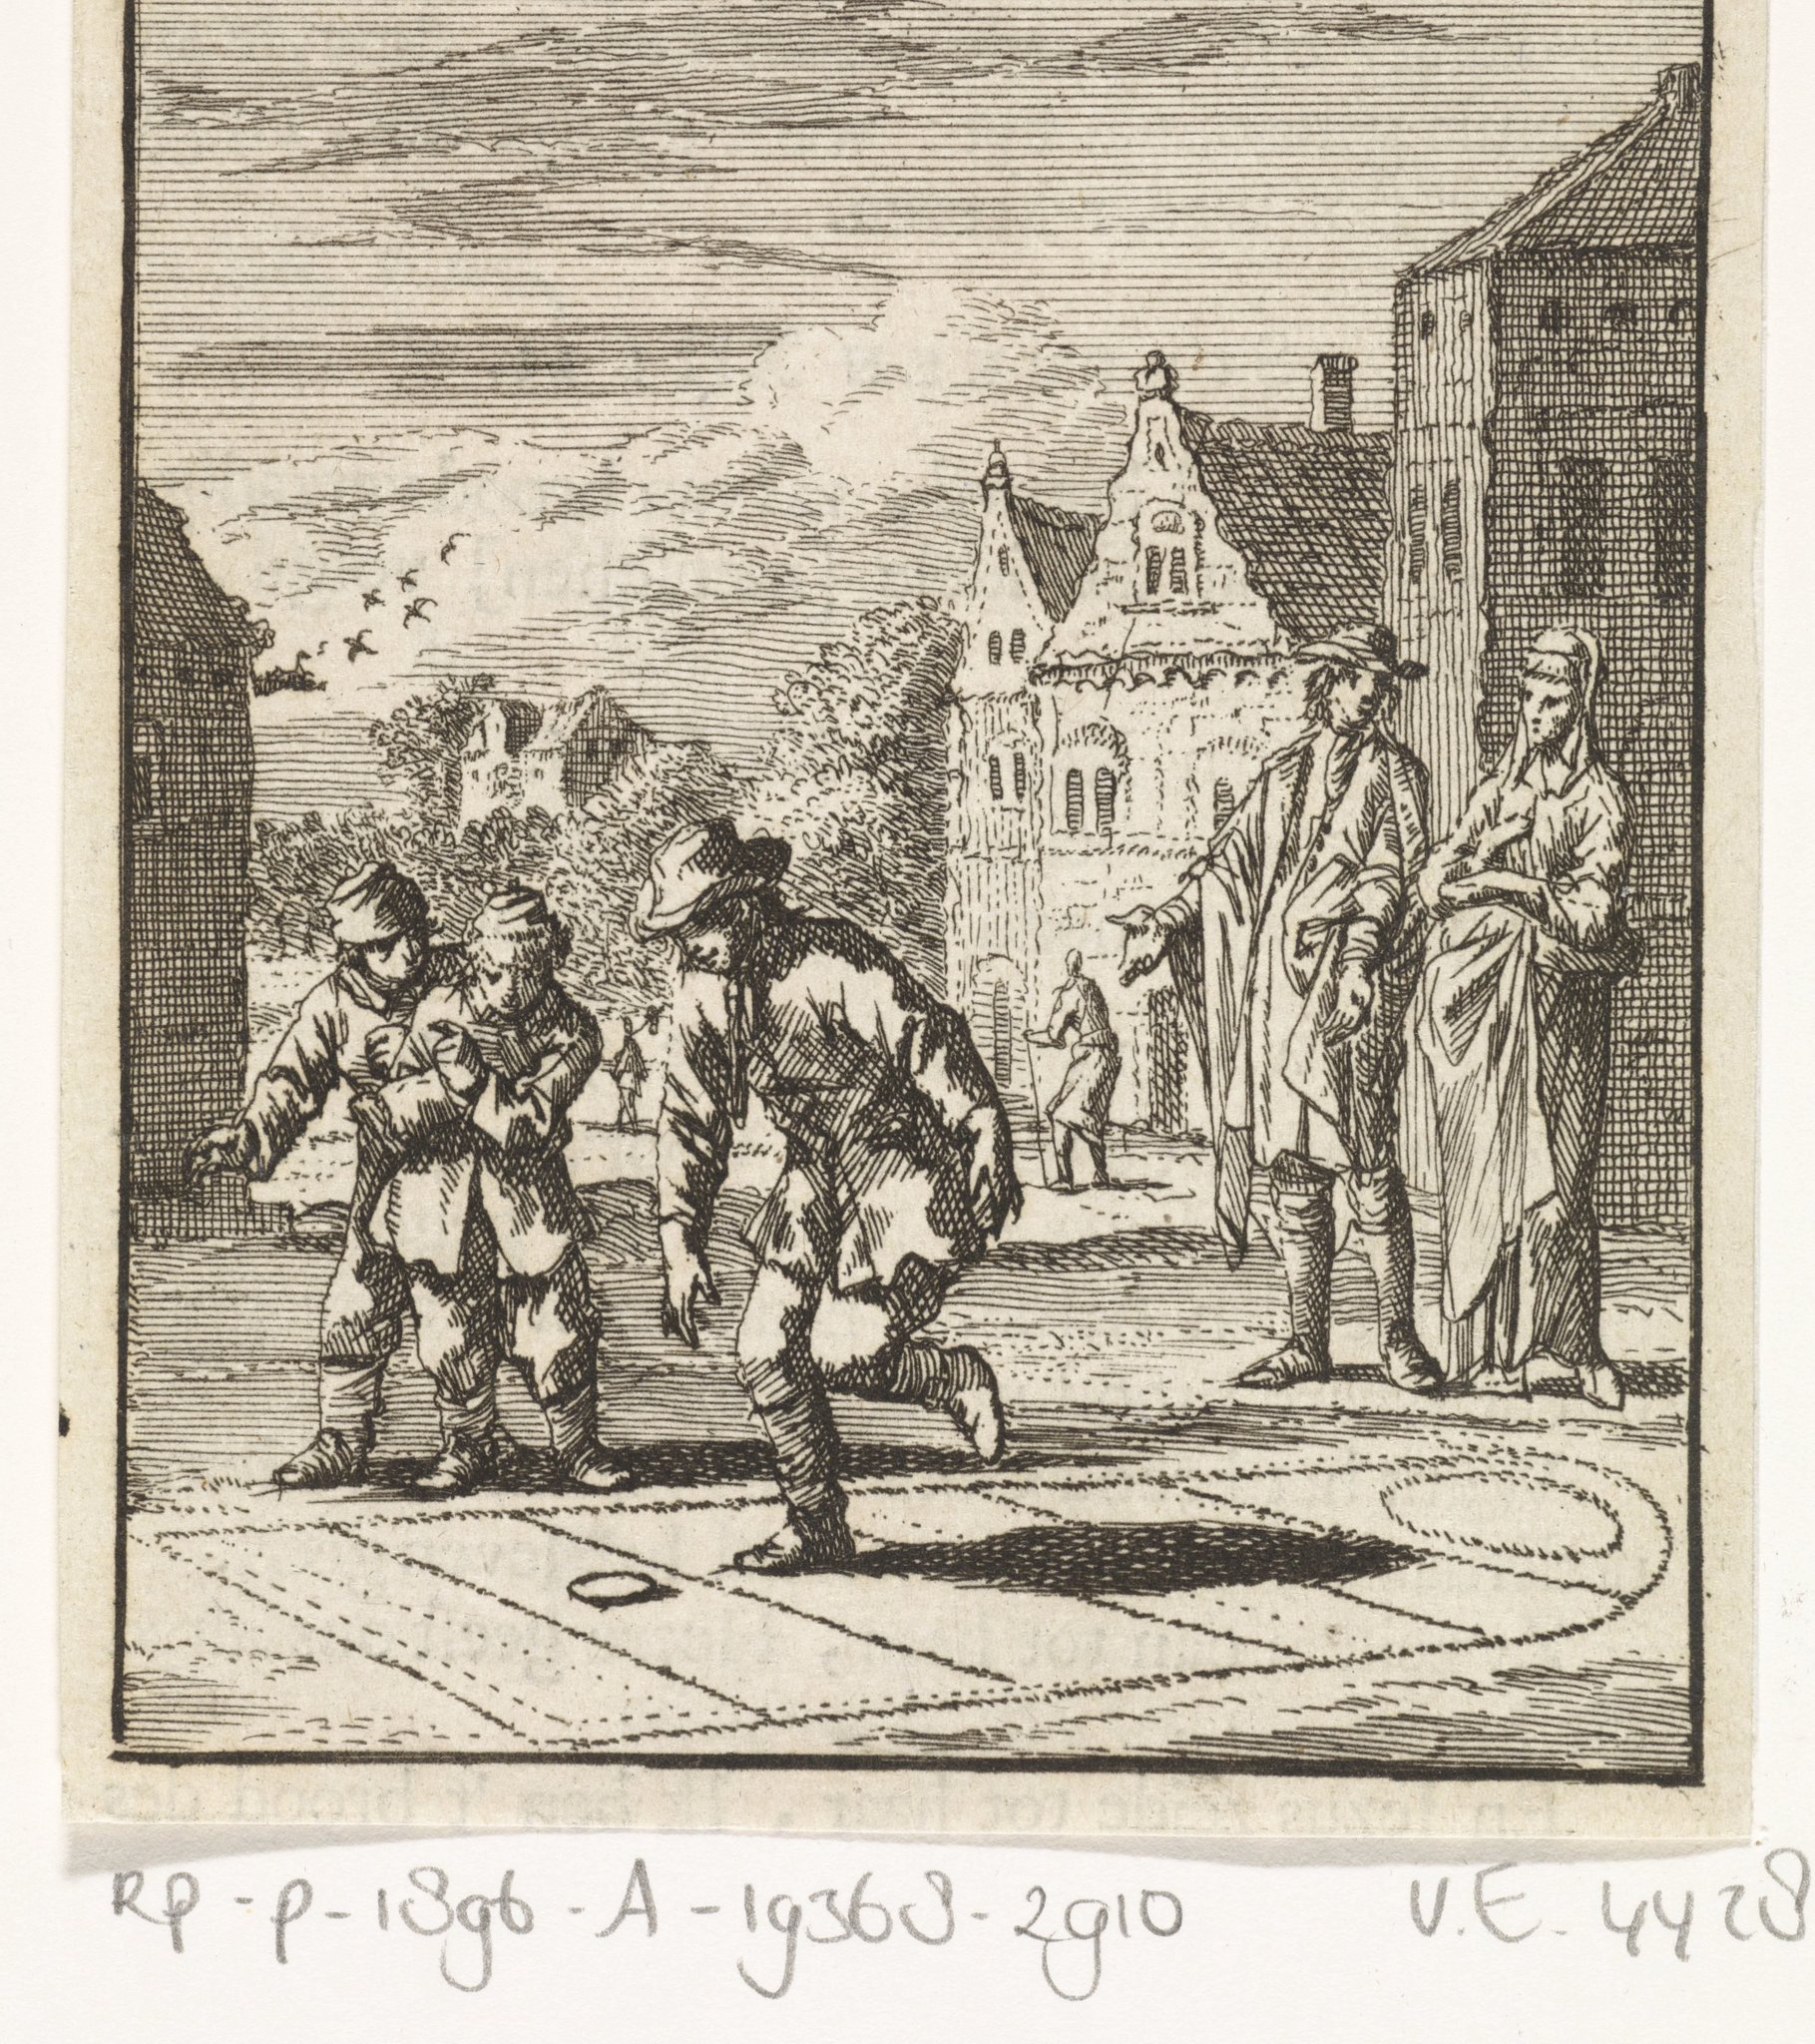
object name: print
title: De Hinkelbaan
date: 1712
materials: paper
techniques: etching, letterpress printing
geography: amsterdam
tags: jumping games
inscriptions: collector's mark: Lugt 2228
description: Illustratie uit: Luyken, Jan. Des menschen begin, midden en einde. Amsterdam: Wed. Pieter Arentsz II en Cornelis van der Sys, 1712, p. 89.